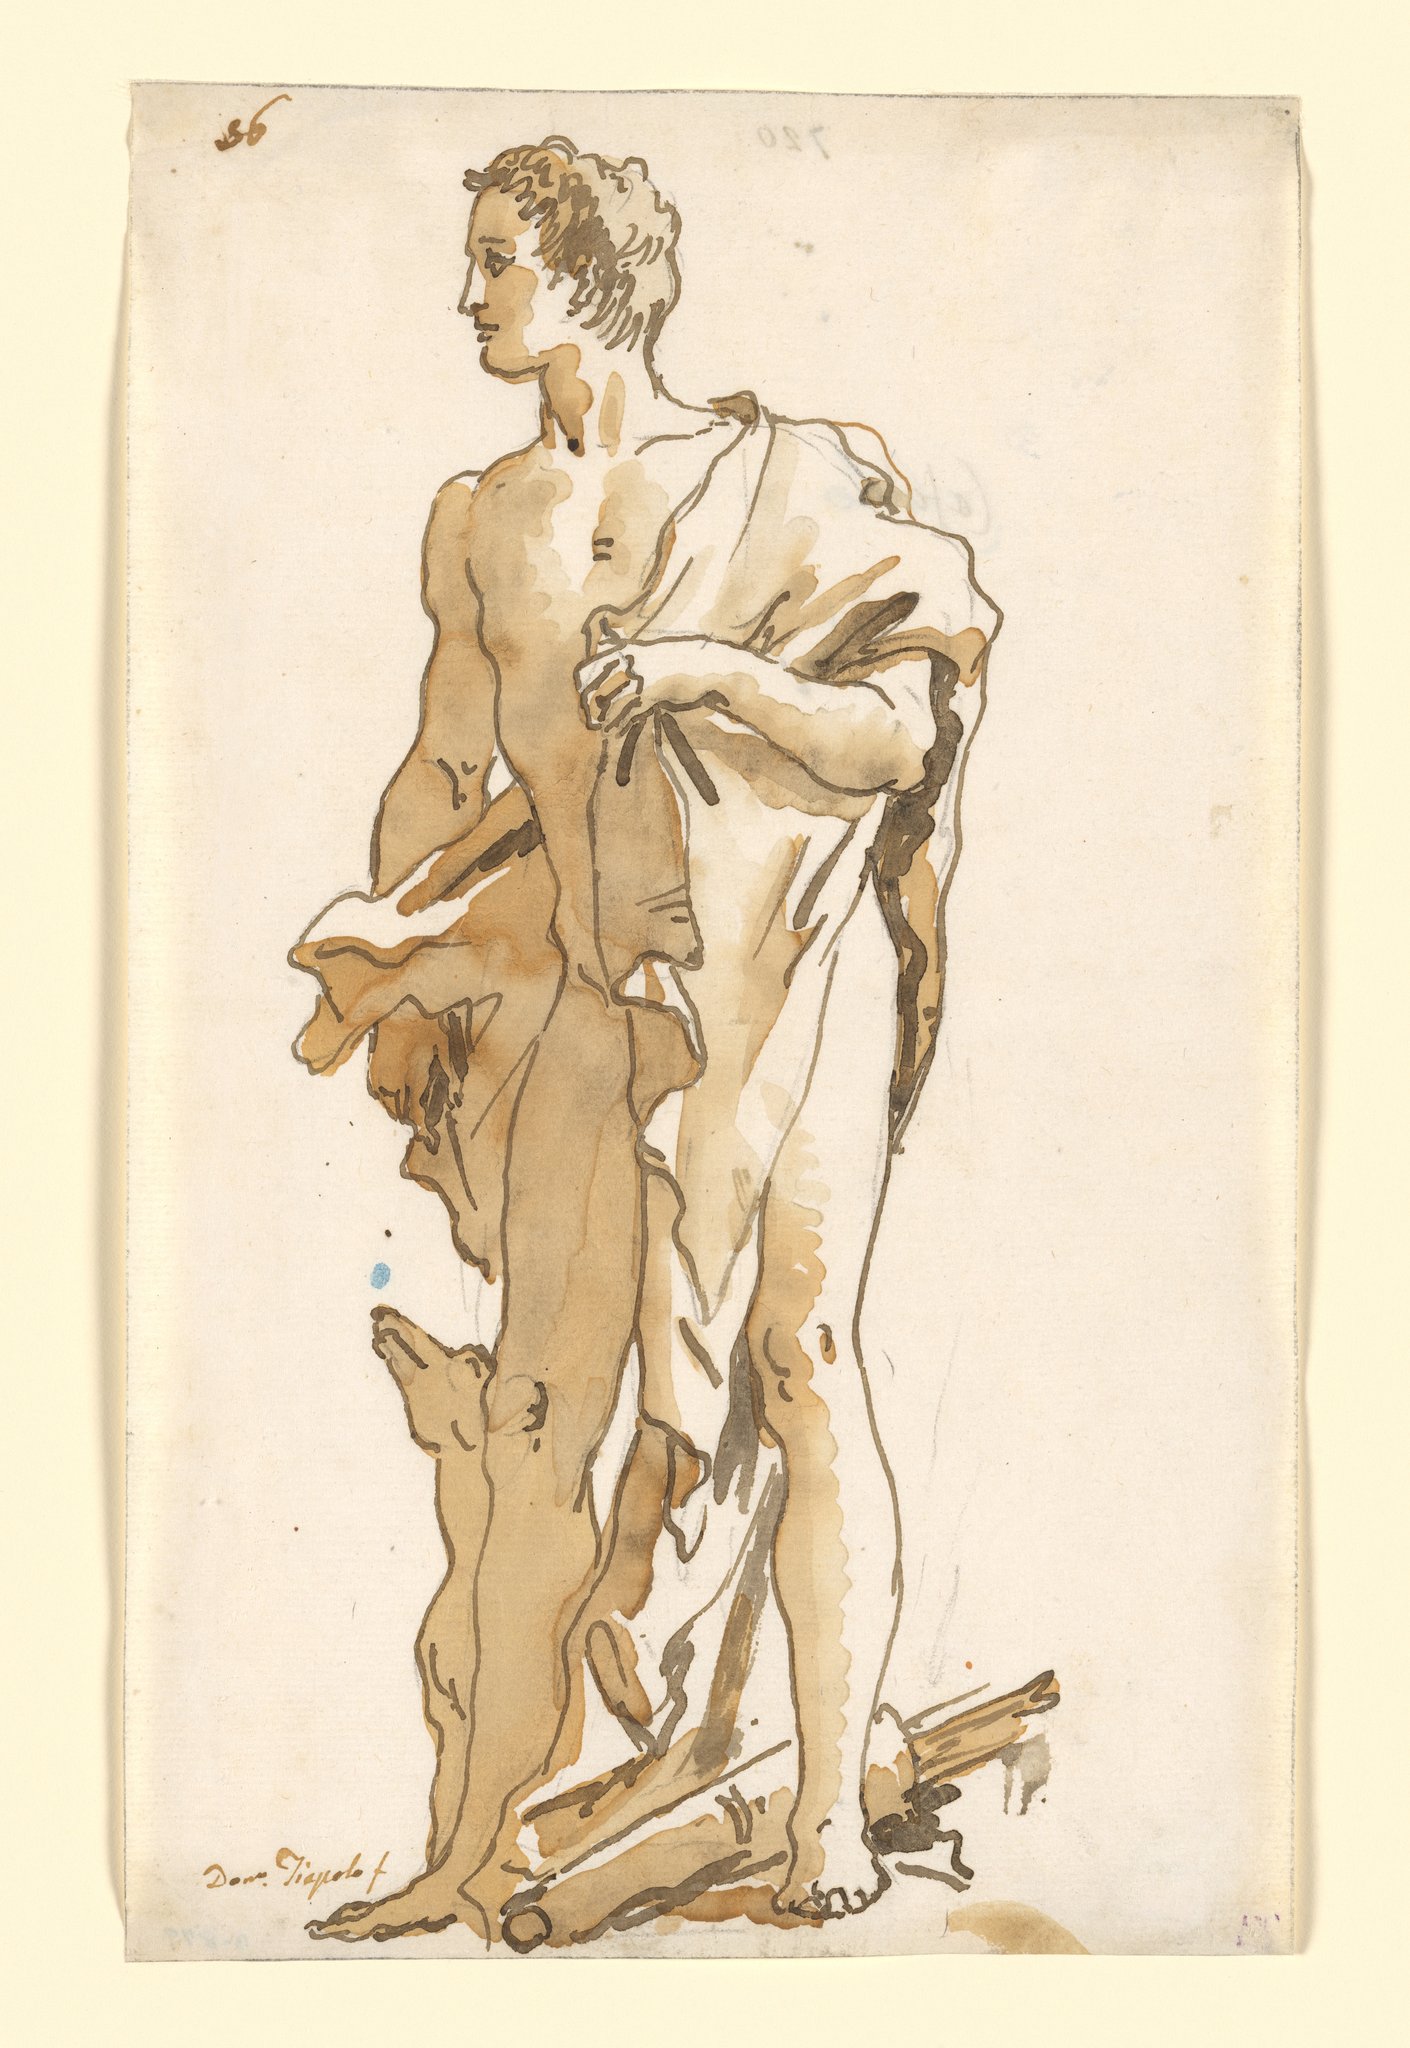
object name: drawing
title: Meleager, Turning to the Left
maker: giovanni domenico tiepolo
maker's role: artist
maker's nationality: italian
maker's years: 1727-1804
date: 1734-1833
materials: chalk, ink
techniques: pen, wash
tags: men